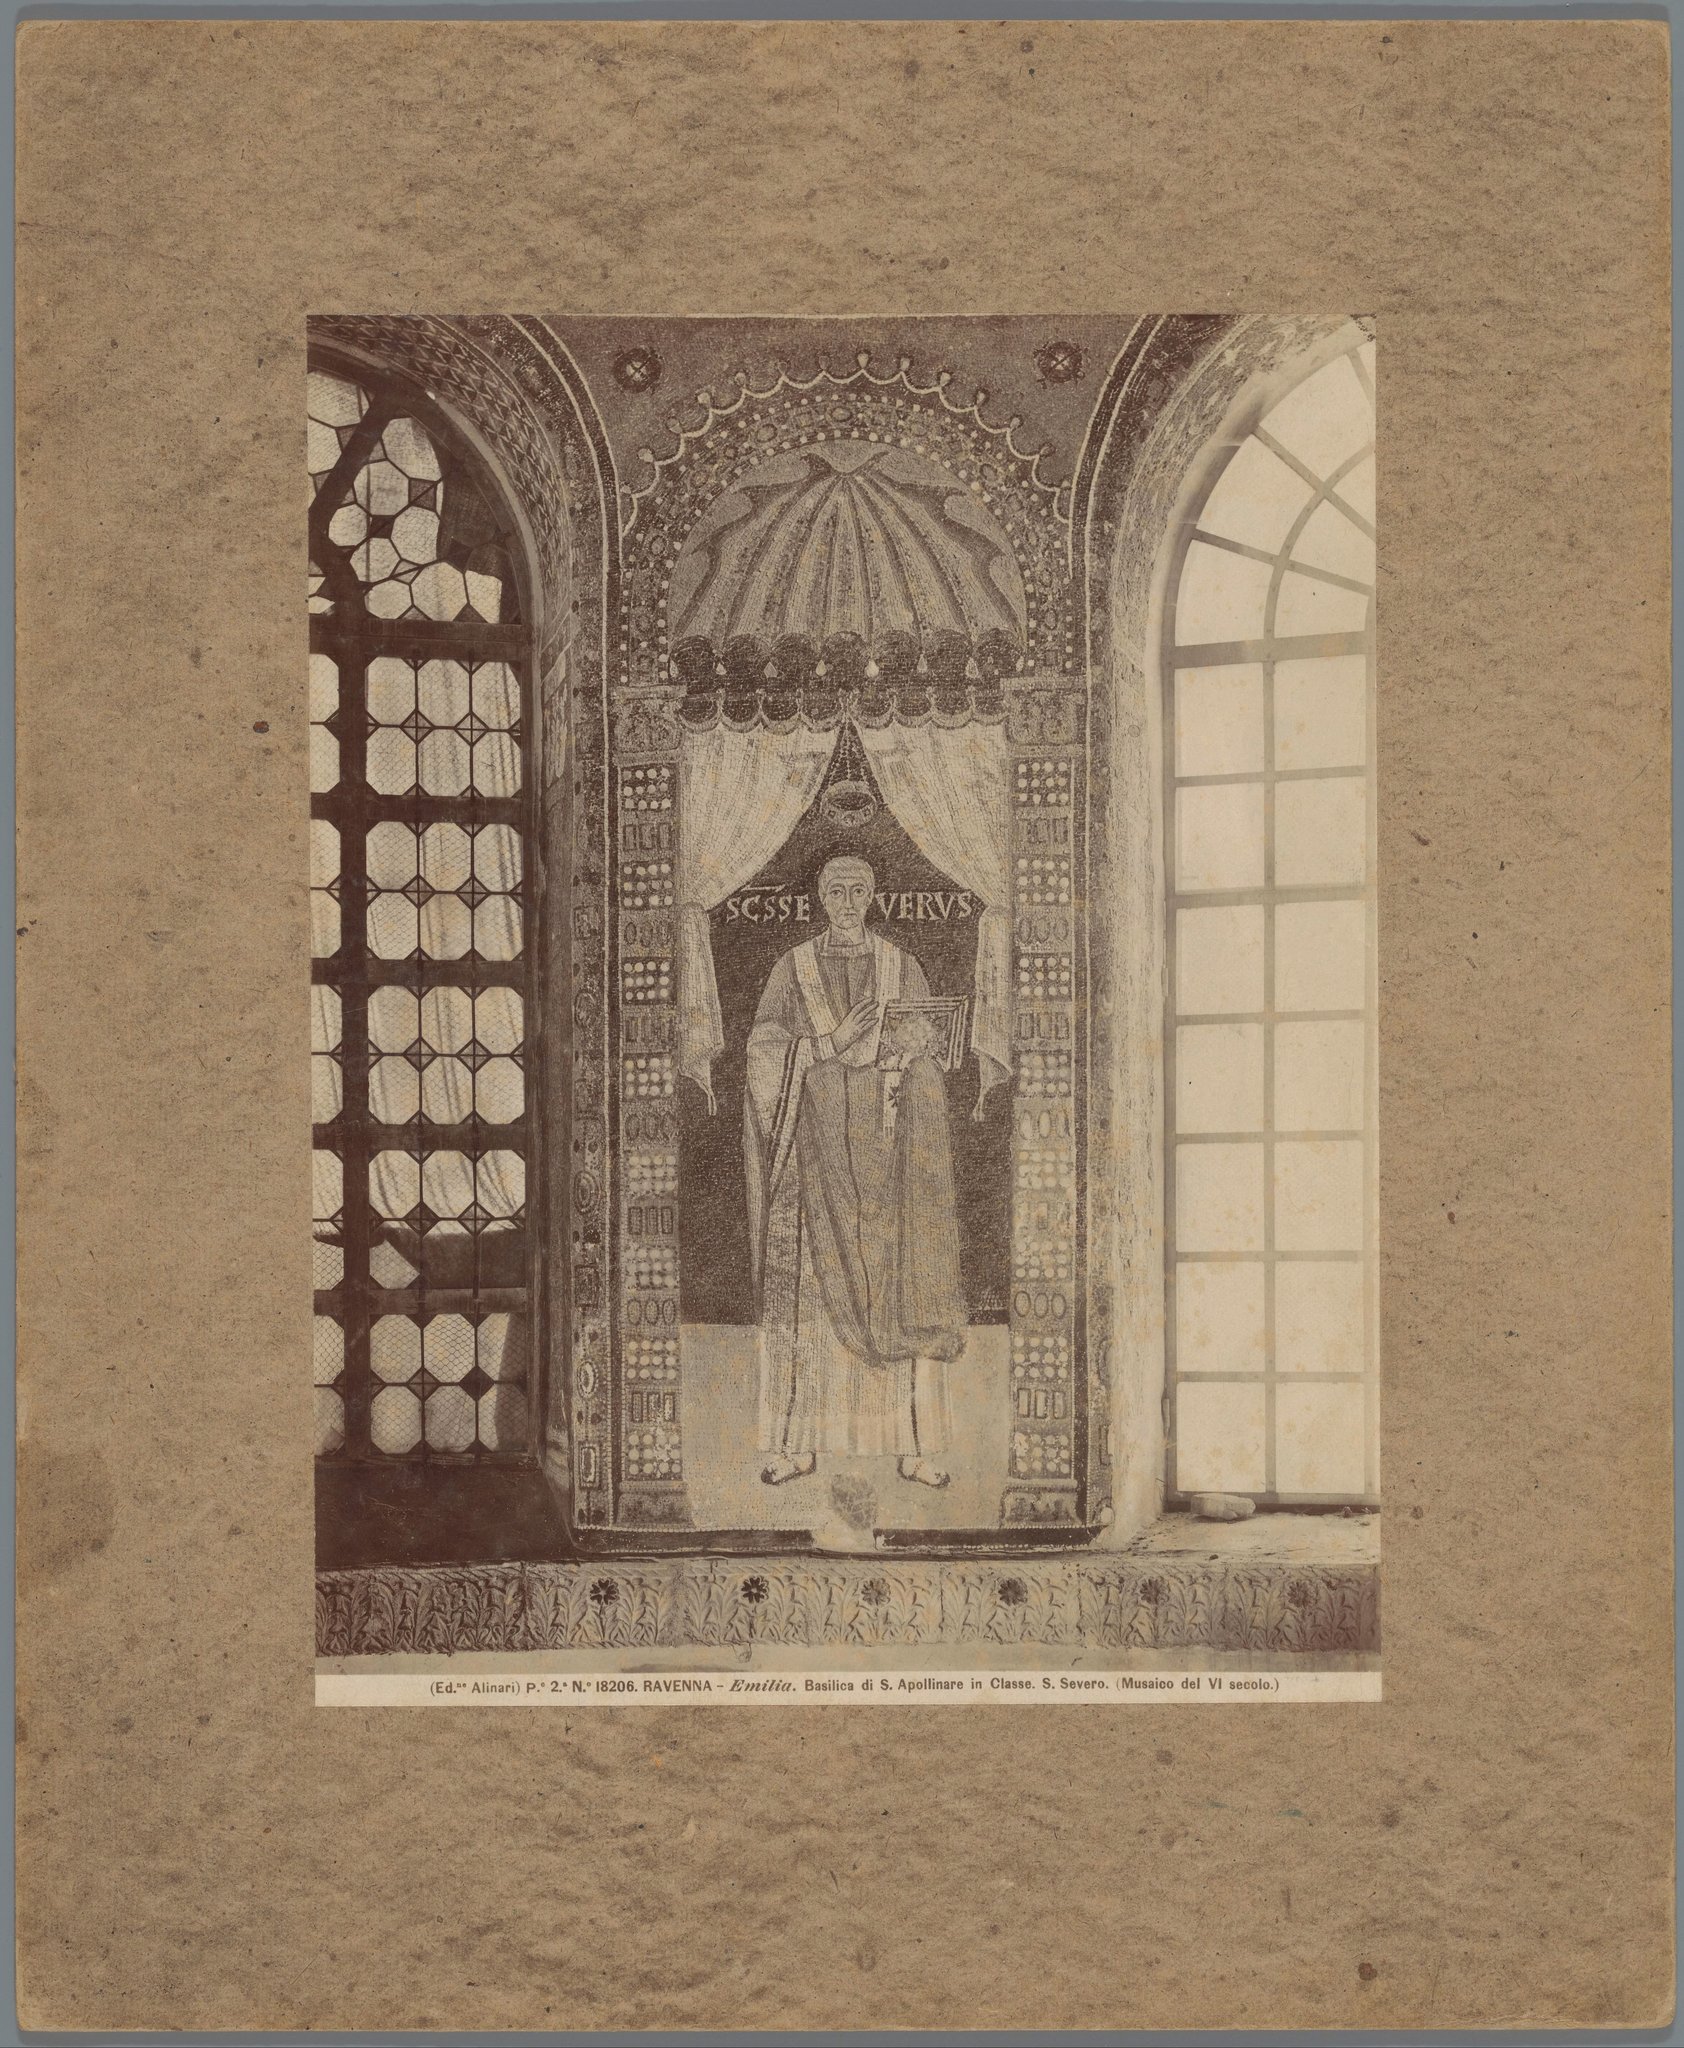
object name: photograph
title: Mozaïek in de Basiliek van Sant'Apollinare in Classe te Ravenna, voorstellende de heilige Severus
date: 1875-1900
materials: cardboard, photographic support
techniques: albumen print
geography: basiliek van sant'apollinare in classe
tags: art (+ mosaic making), the weaver severus, bishop of ravenna; possible attributes: dove, weaver's loom and tools, interior of church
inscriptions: collector's mark: Lugt 3937, number: ‘P.e 2.a N.o 18206.’